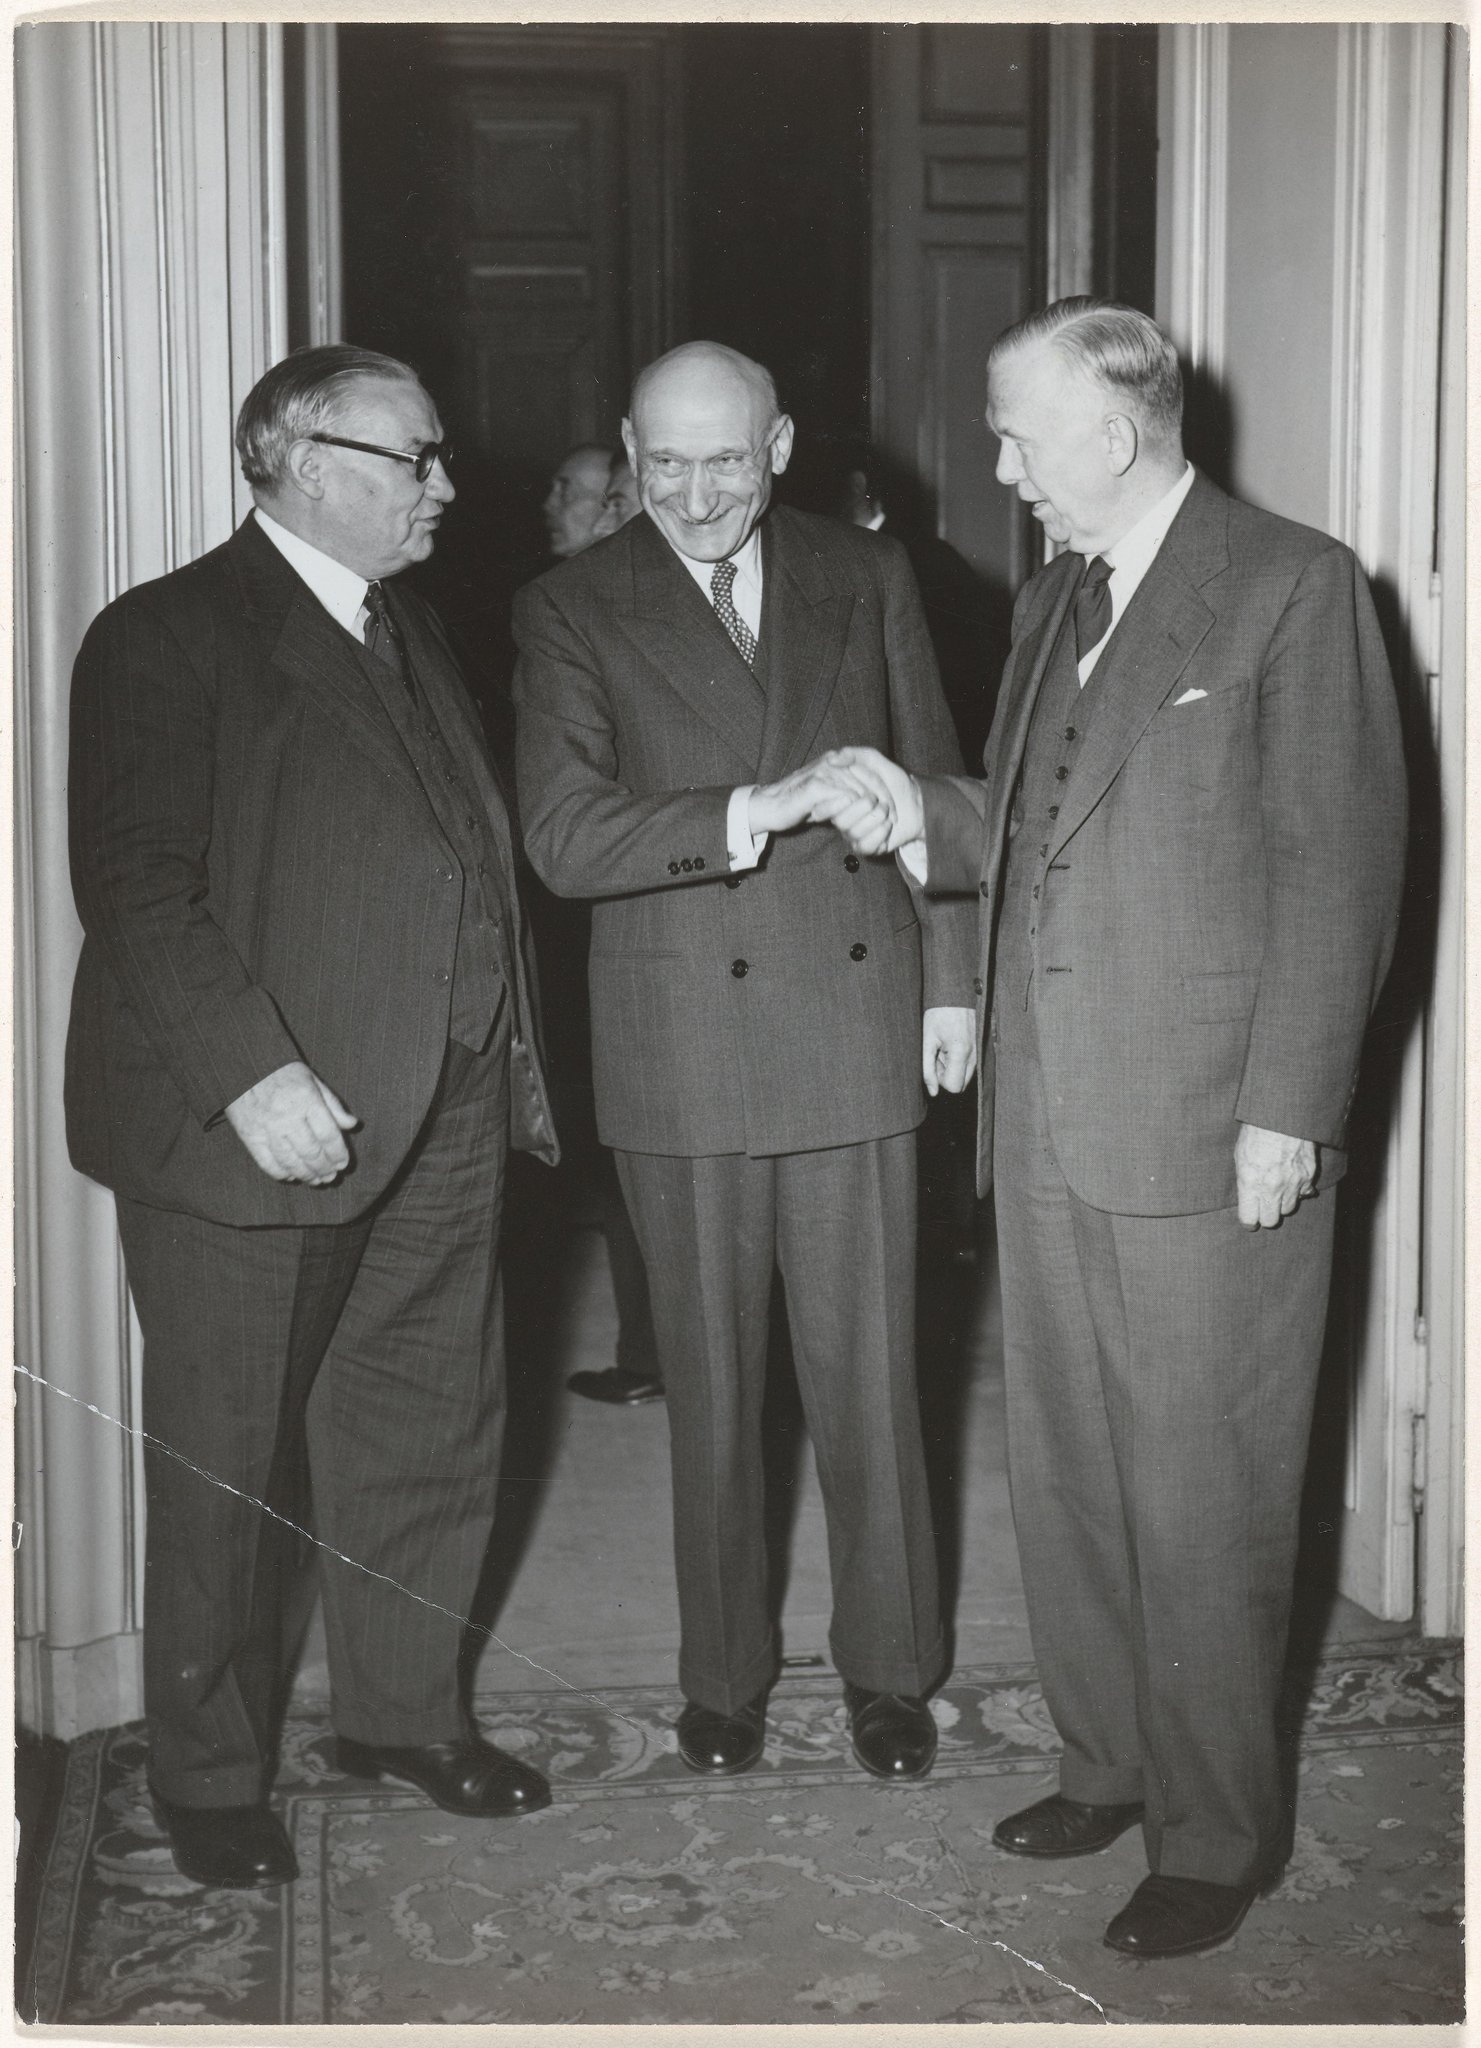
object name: photograph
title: Portret van G. Marshall, R. Schuman en E. Bevin bij onderhoud in Parijs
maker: rene helier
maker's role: fotograaf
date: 1948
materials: photographic support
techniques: gelatin silver print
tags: politician, paris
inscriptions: stamp: ‘Copyright INP International News Photos Paris...’, stamp: ‘Copyright Photo press Belgium S.A. ...’